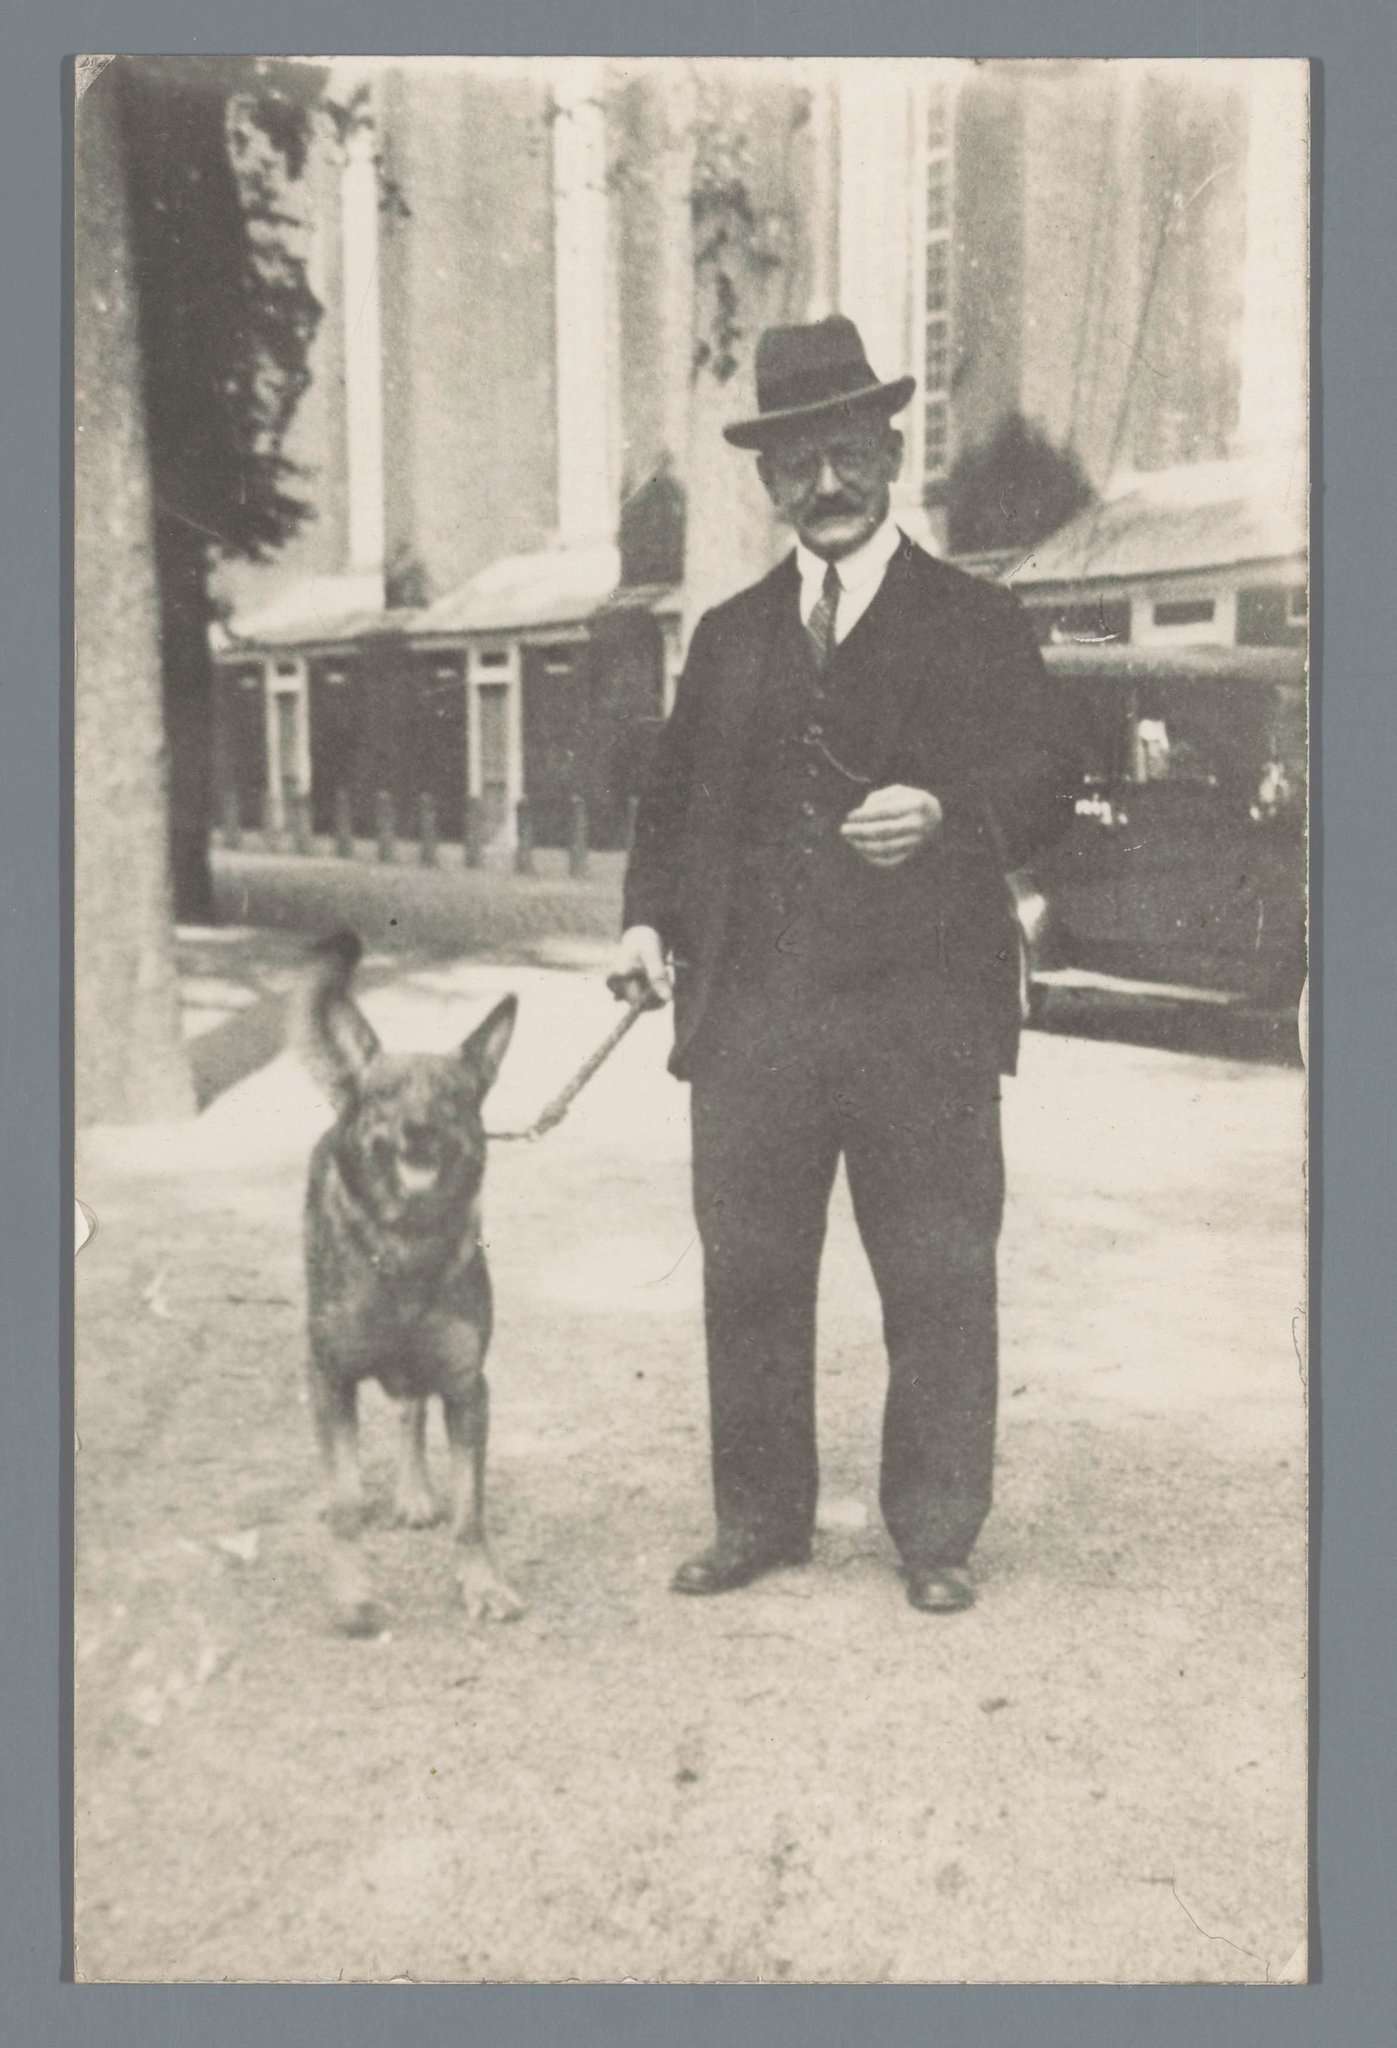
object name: photograph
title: Portret van een onbekende man met een hond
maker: Anonymous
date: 1907-1920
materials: photographic support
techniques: gelatin silver print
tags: adult man, dog